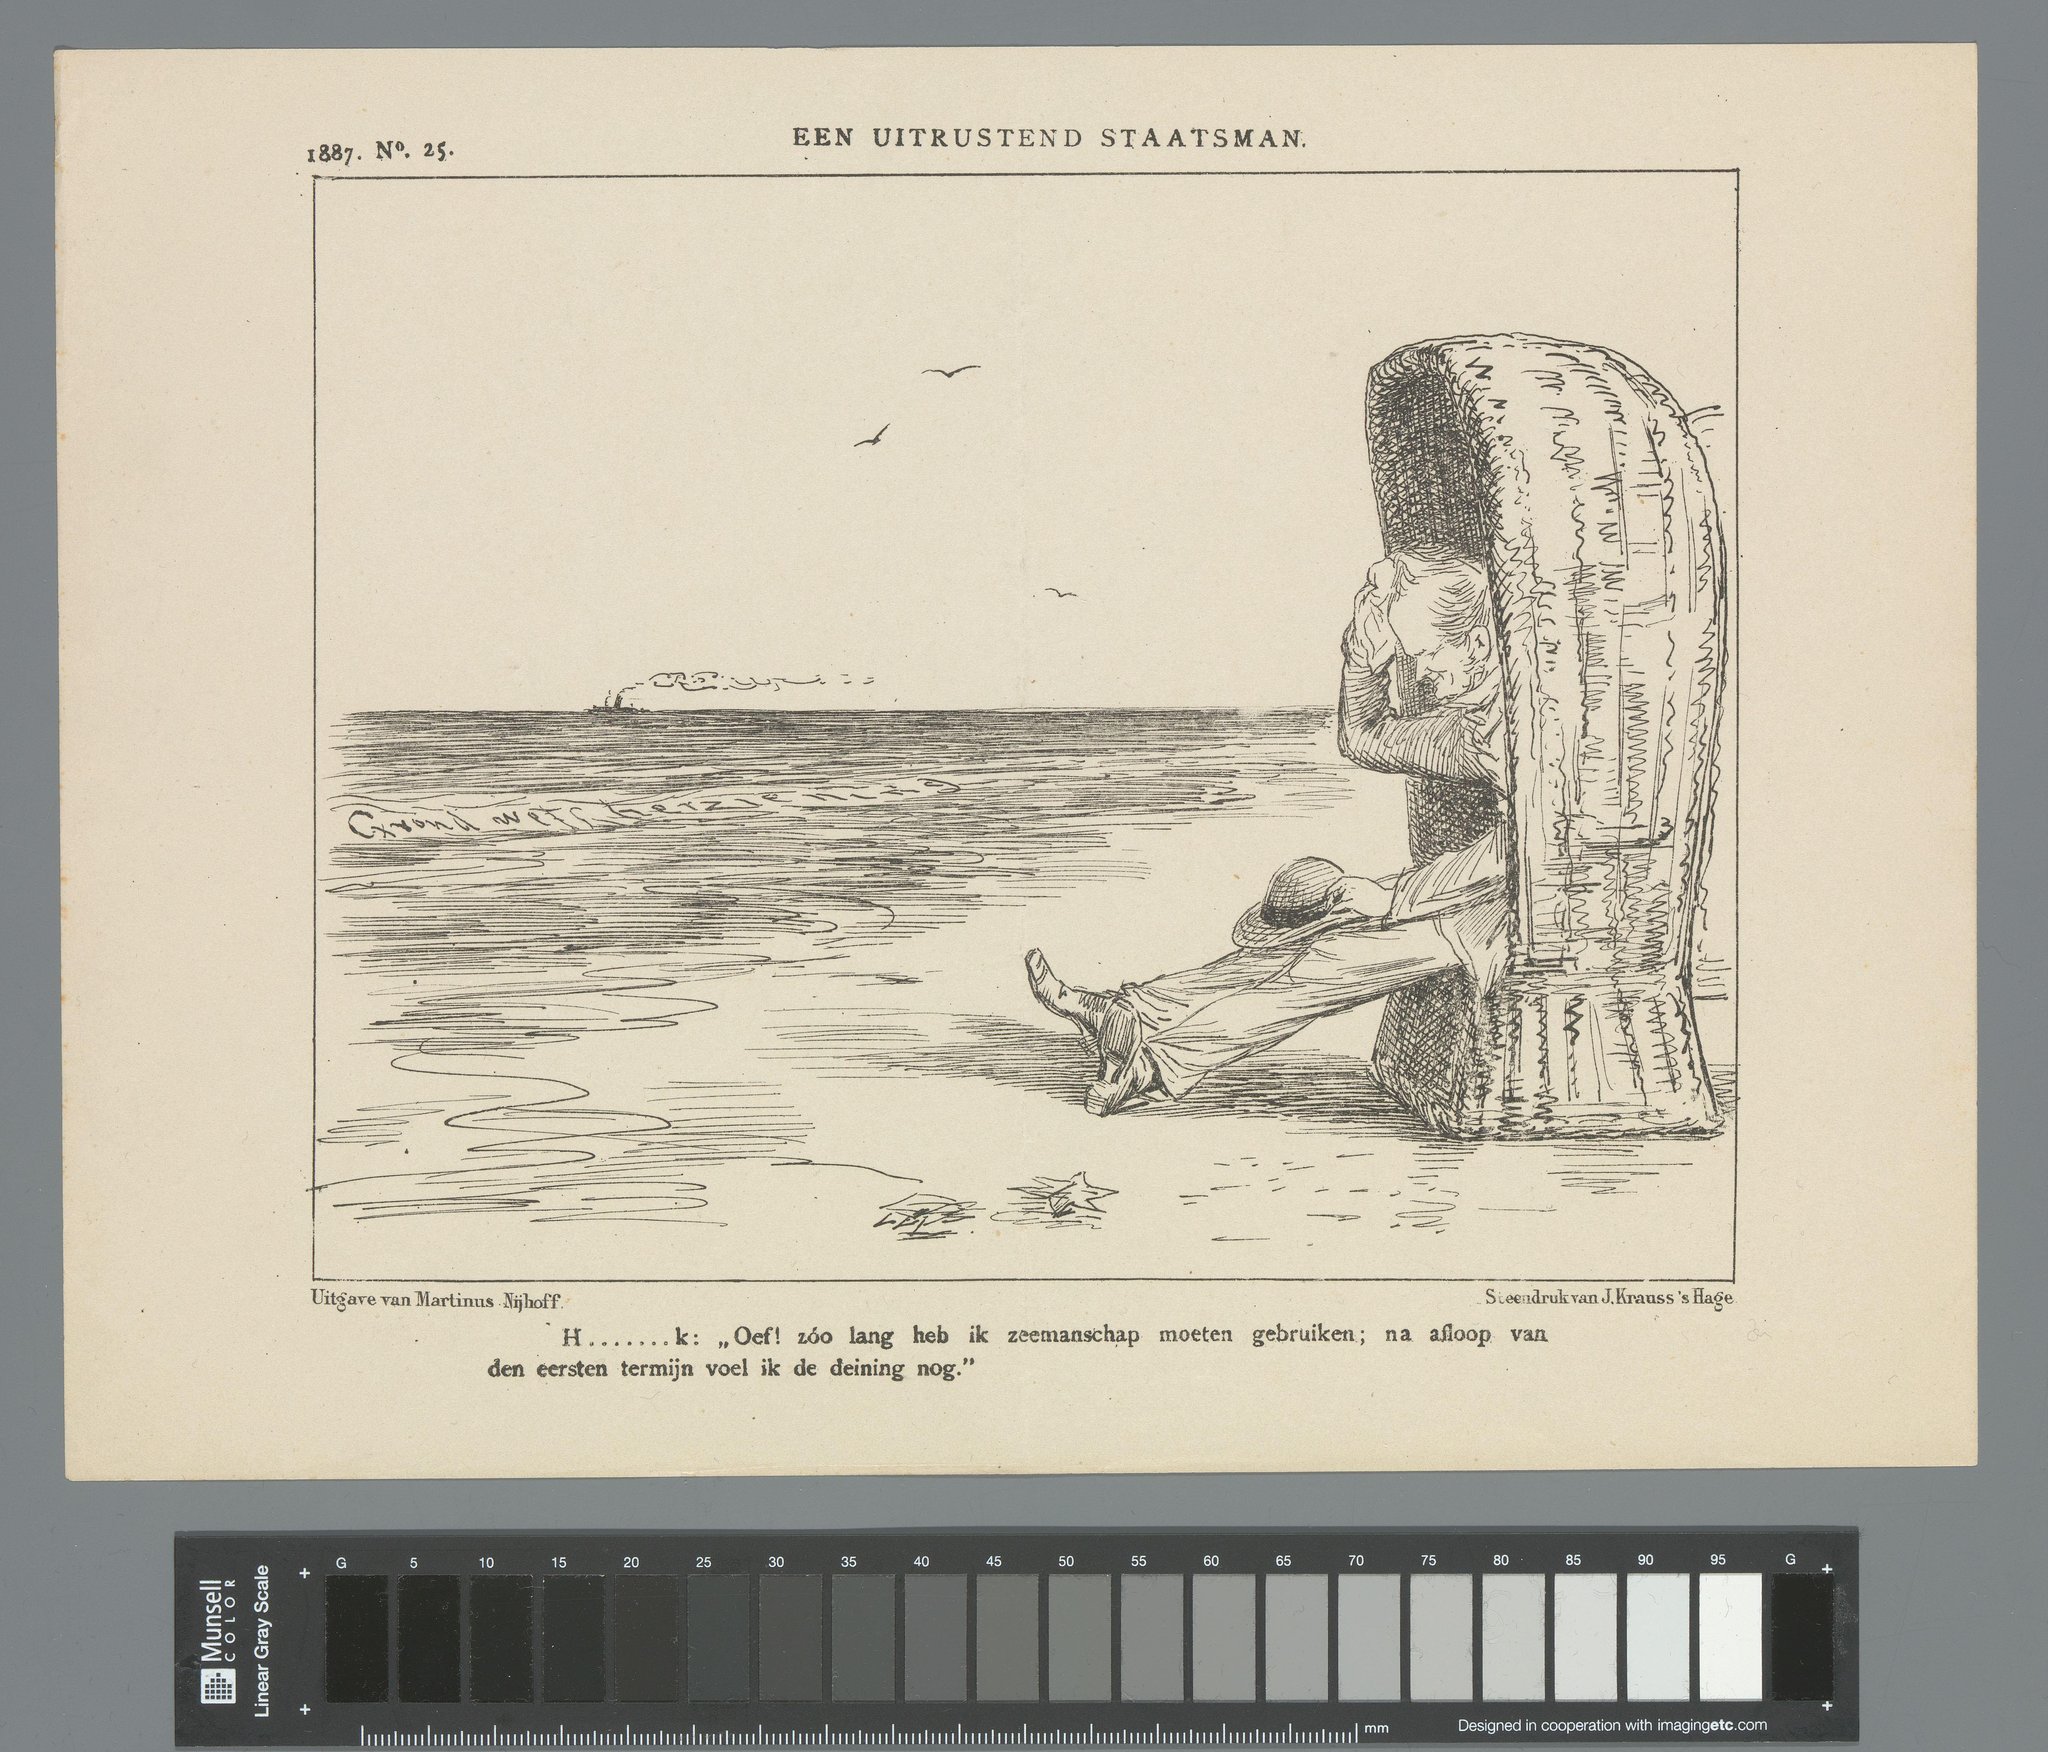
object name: print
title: Spotprent met minister Heemskerk, 1887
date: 1887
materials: paper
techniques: lithograph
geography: the hague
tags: tweede kamerlid, minister van binnenlandse zaken, minister van justitie, jan heemskerk azn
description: Spotprent met minister Heemskerk die op het strand uitrust. Plaat verschenen bij het weekblad De Nederlandsche Spectator, nr. 25, 1887.